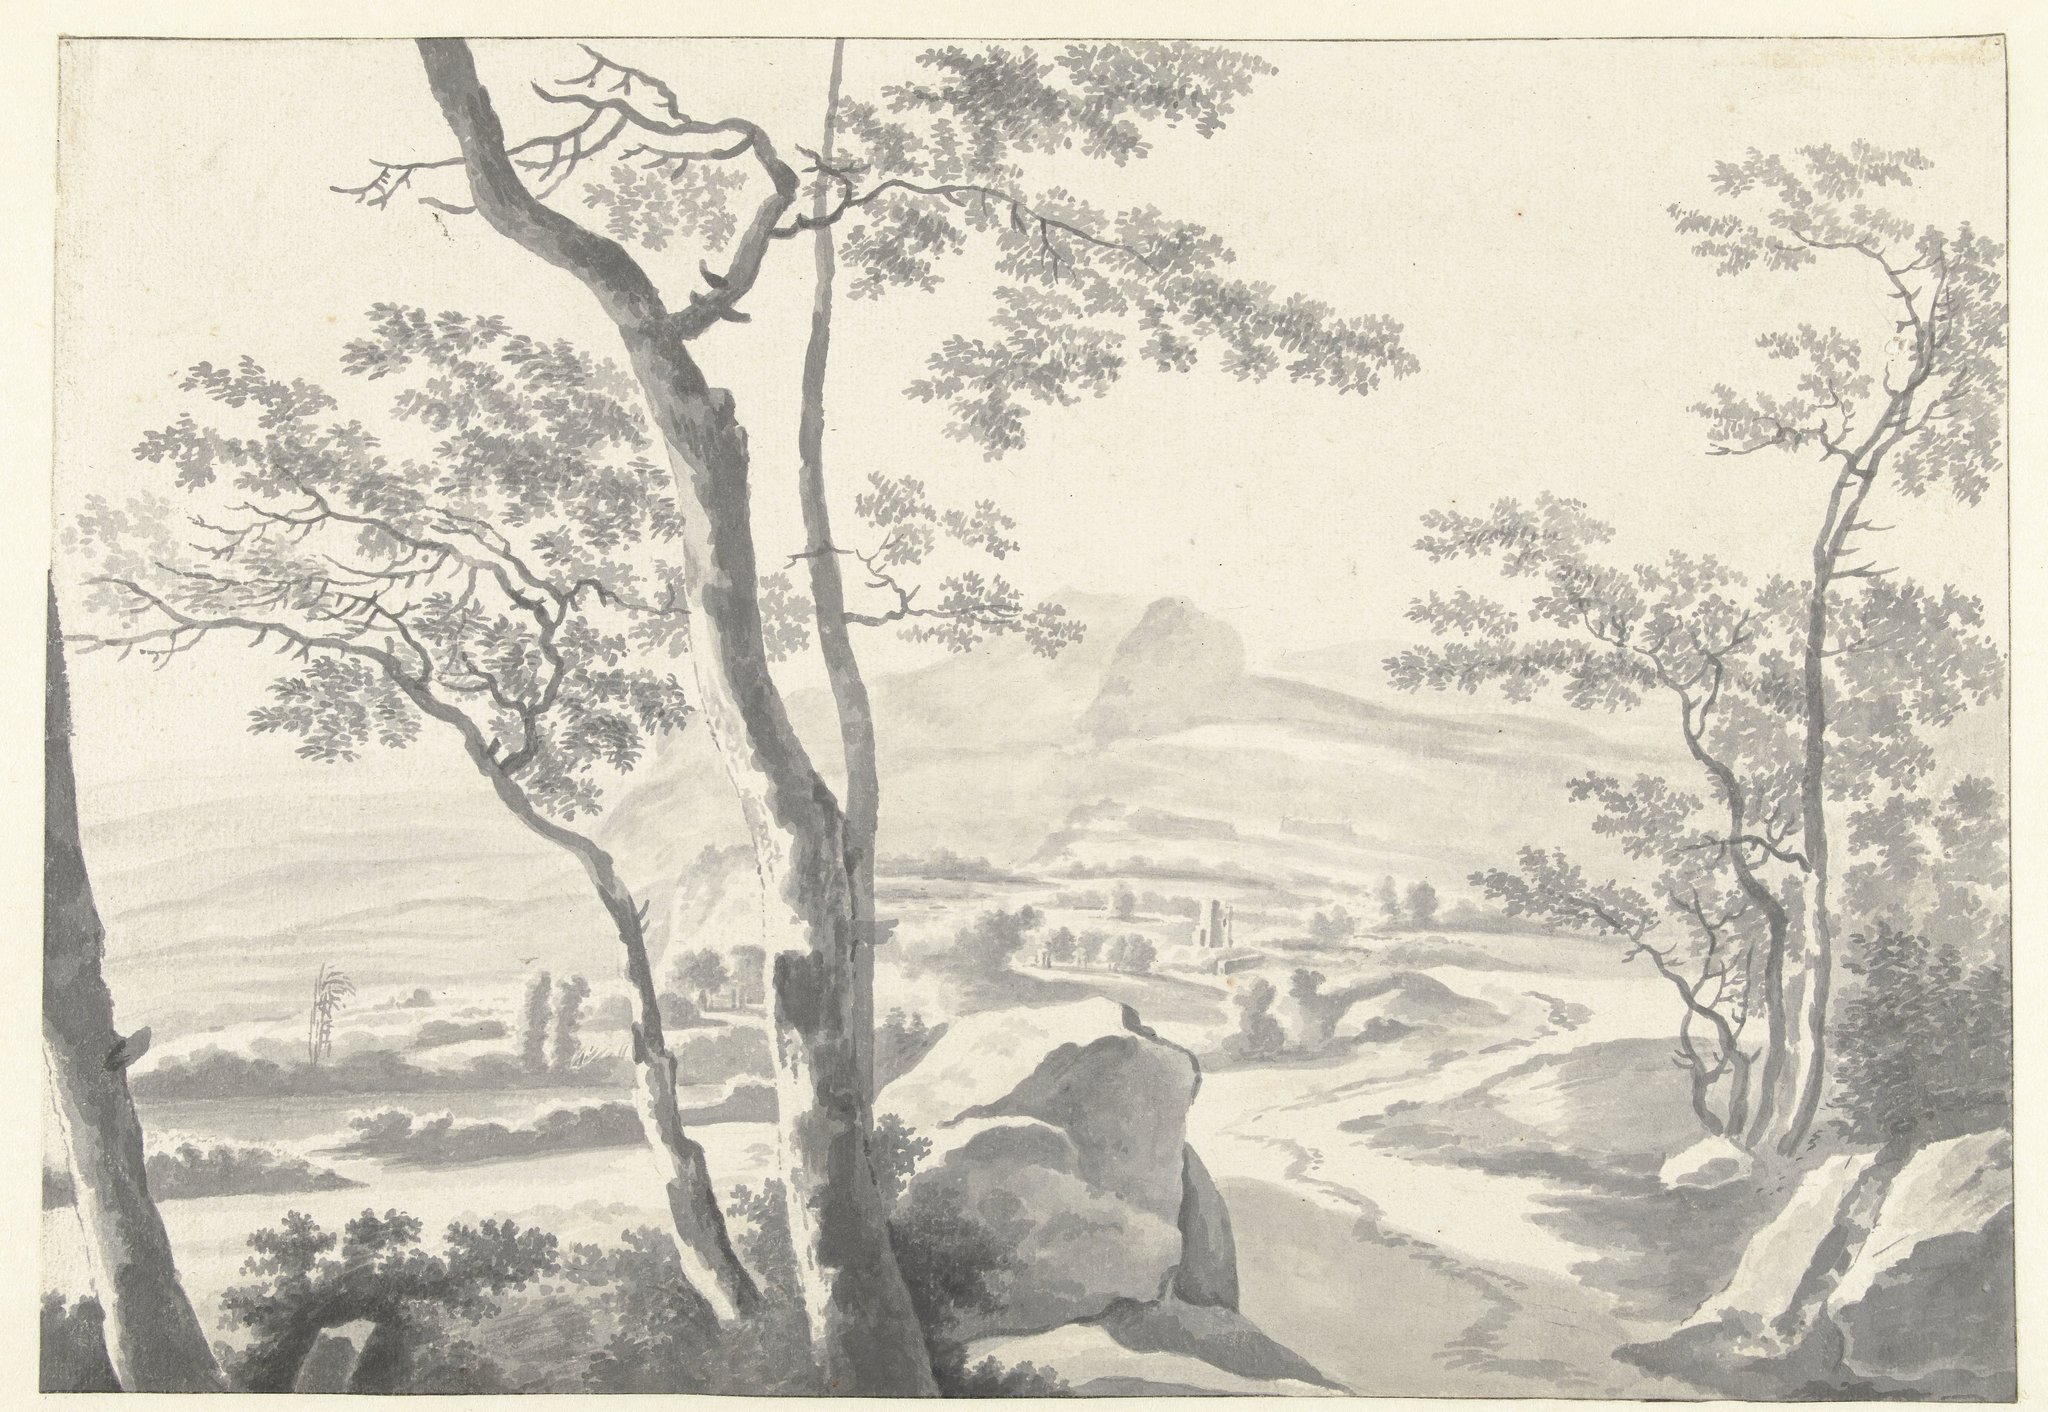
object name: drawing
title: Landschap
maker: jan both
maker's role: draughtsman, painter, print maker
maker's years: 1618-1652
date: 1628-1652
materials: paper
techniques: brush